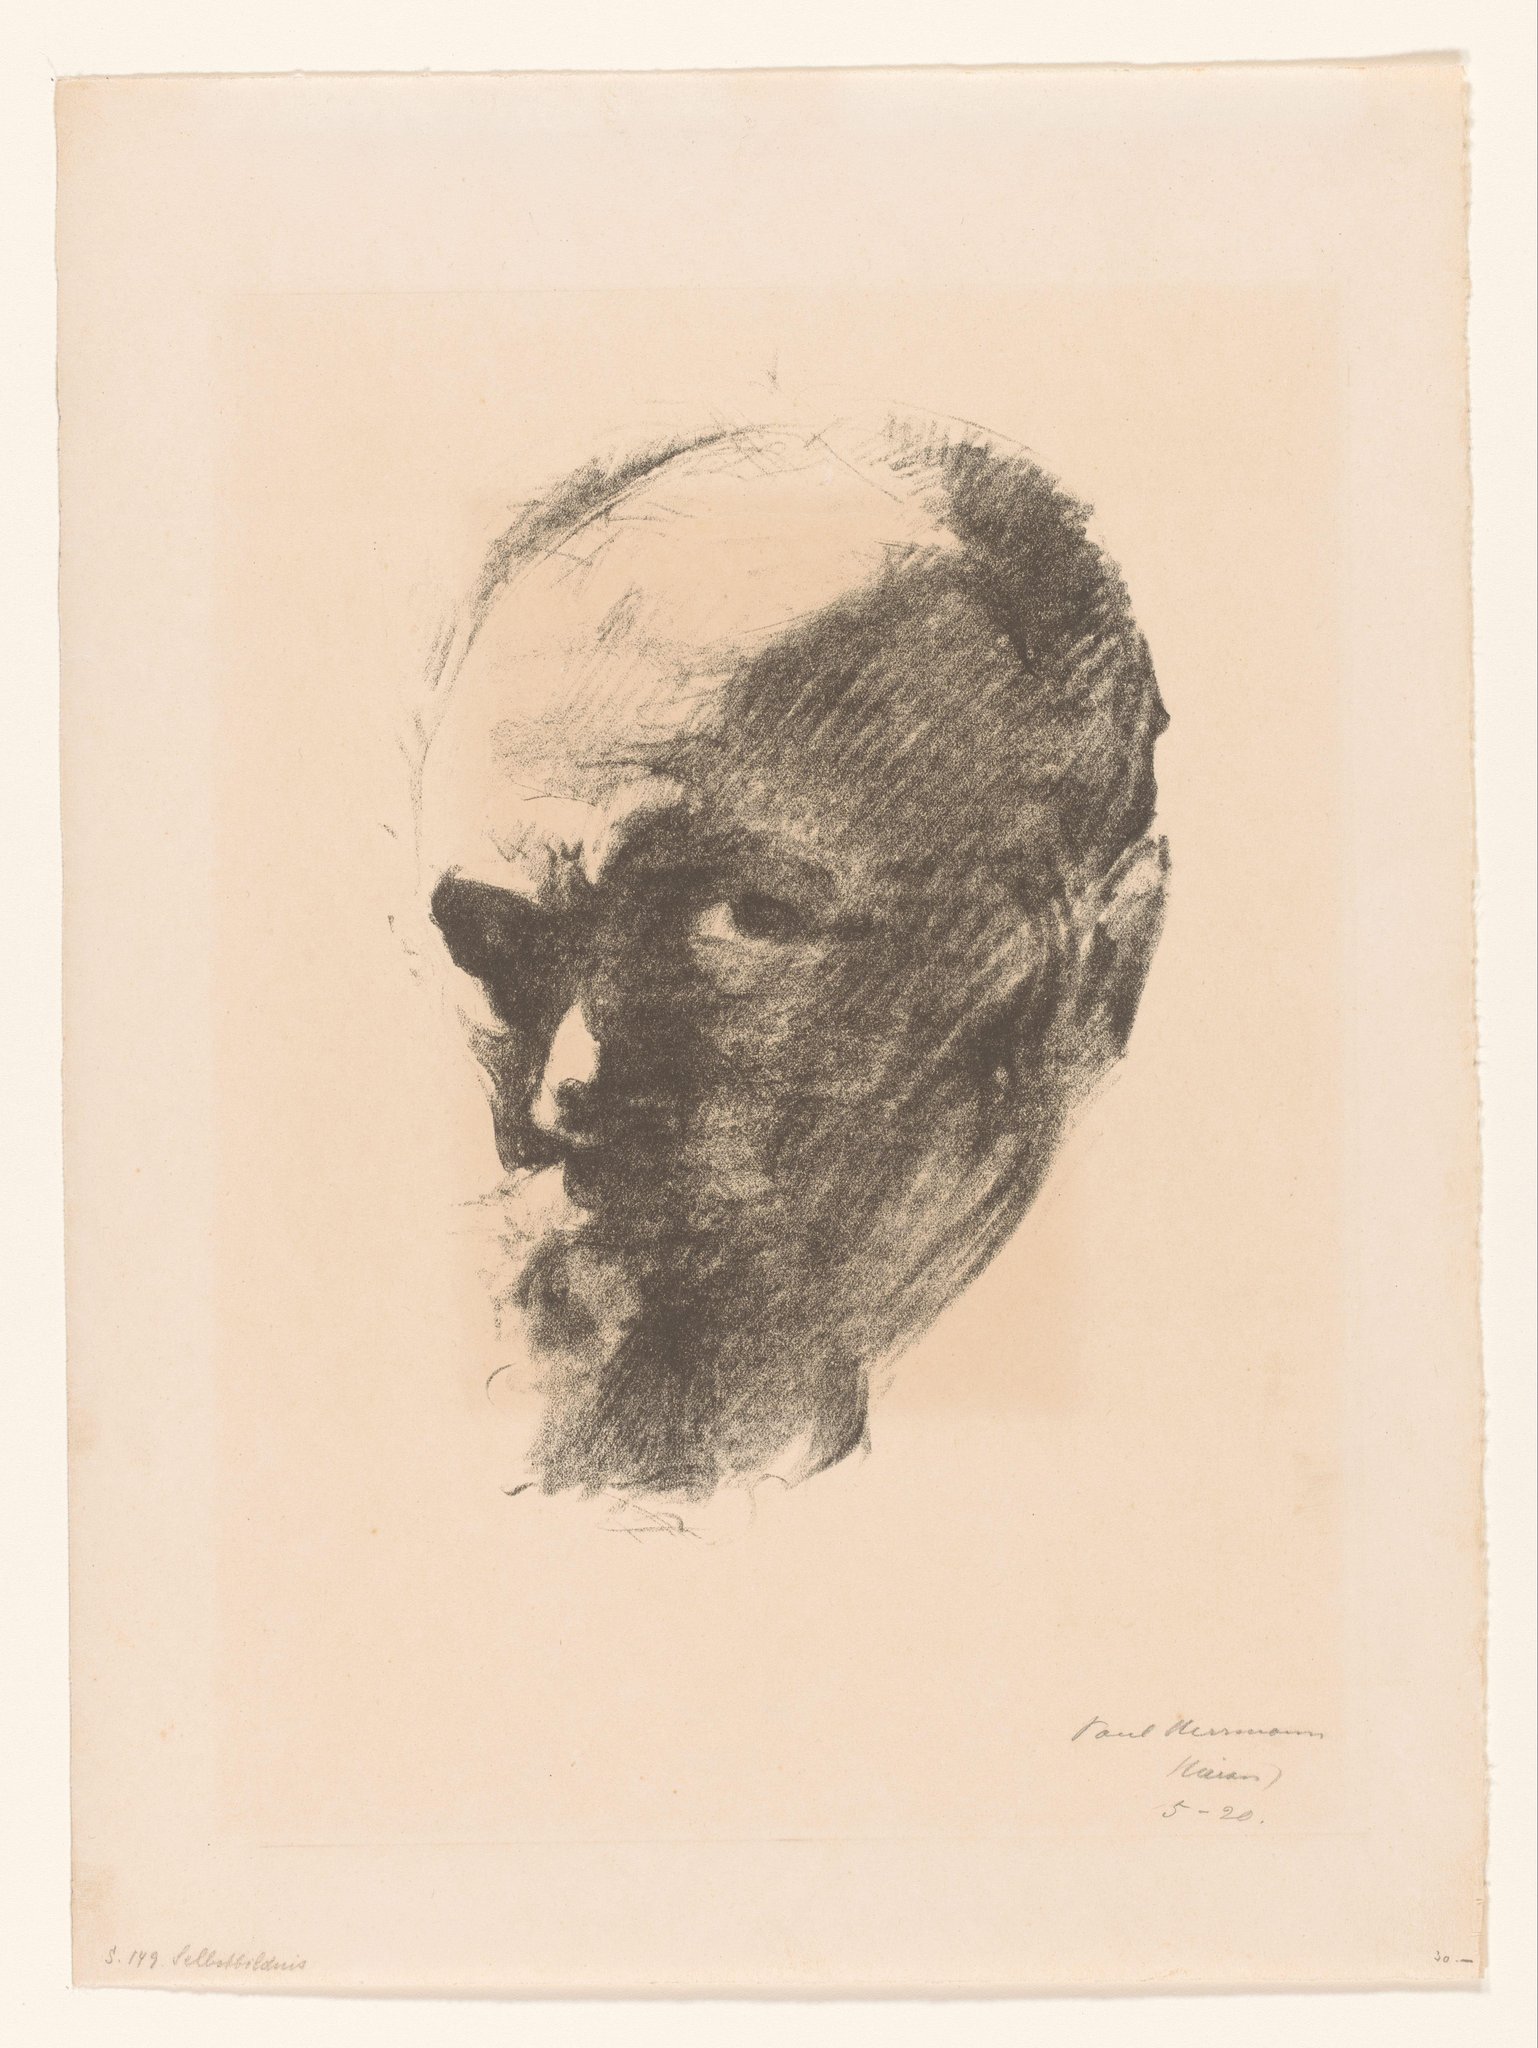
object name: print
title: Zelfportret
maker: paul herrmann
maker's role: painter, print maker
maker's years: 1864-1944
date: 1874-1944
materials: paper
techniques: lithograph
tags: painter, paul herrmann, portrait, self-portrait of artist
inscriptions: collector's mark: Lugt 2228